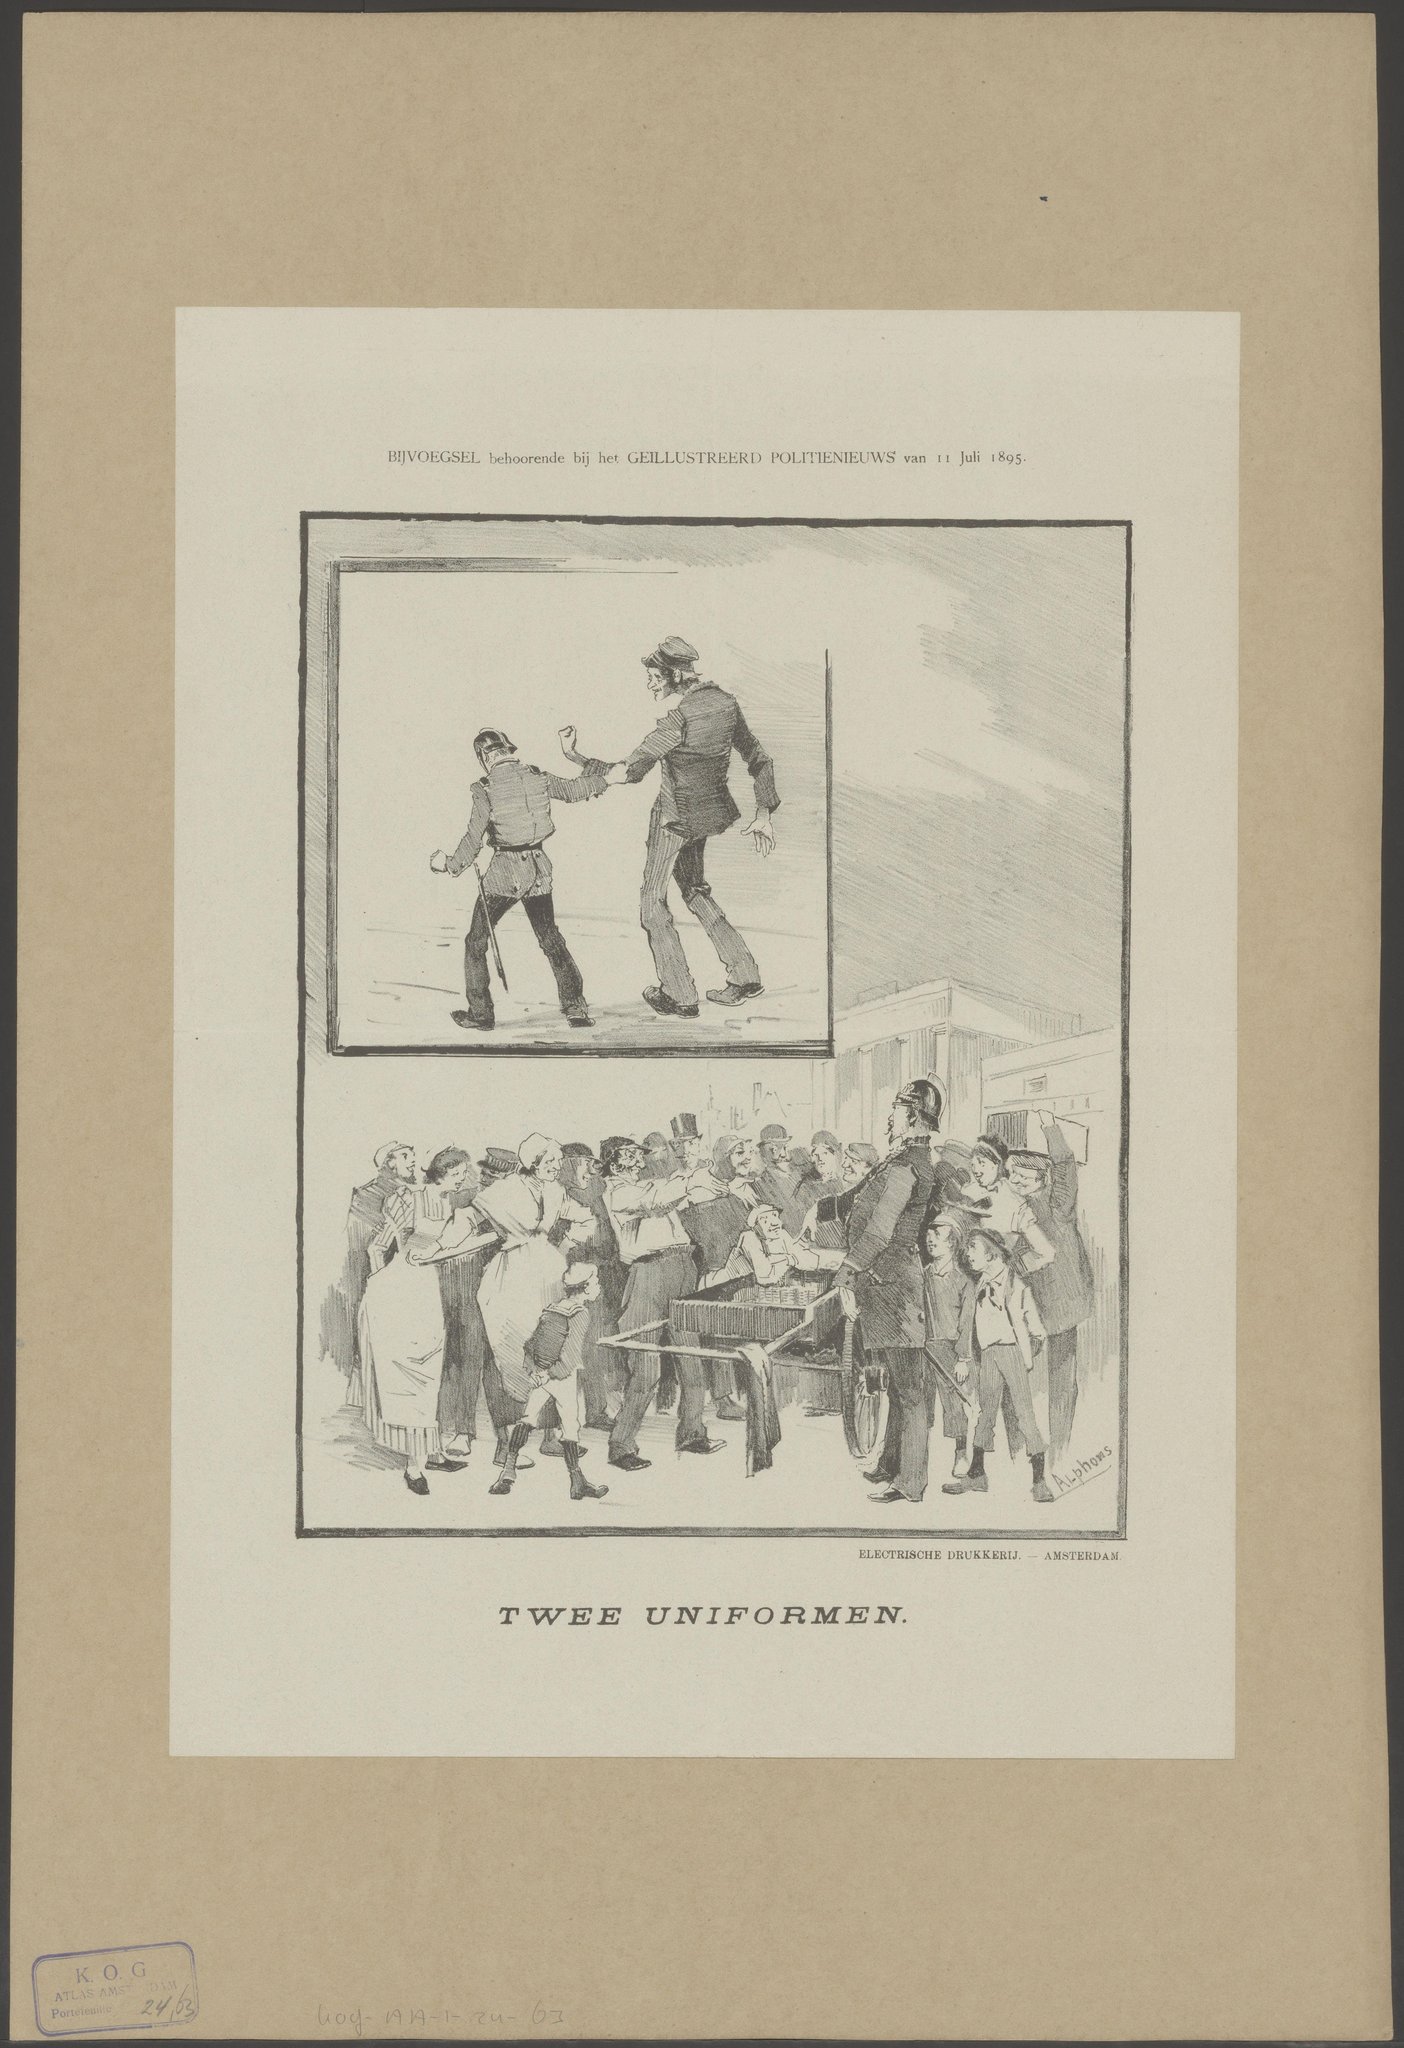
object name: cartoon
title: Twee uniformen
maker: alphons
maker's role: print maker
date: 1895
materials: paper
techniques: letterpress printing, lithograph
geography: netherlands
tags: crowd, mob, policeman, constable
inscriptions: collector's mark: Lugt 1641b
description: Gepubliceerd als bijvoegsel van 'Het Geïllustreerd Politienieuws', 11 juli 1895.